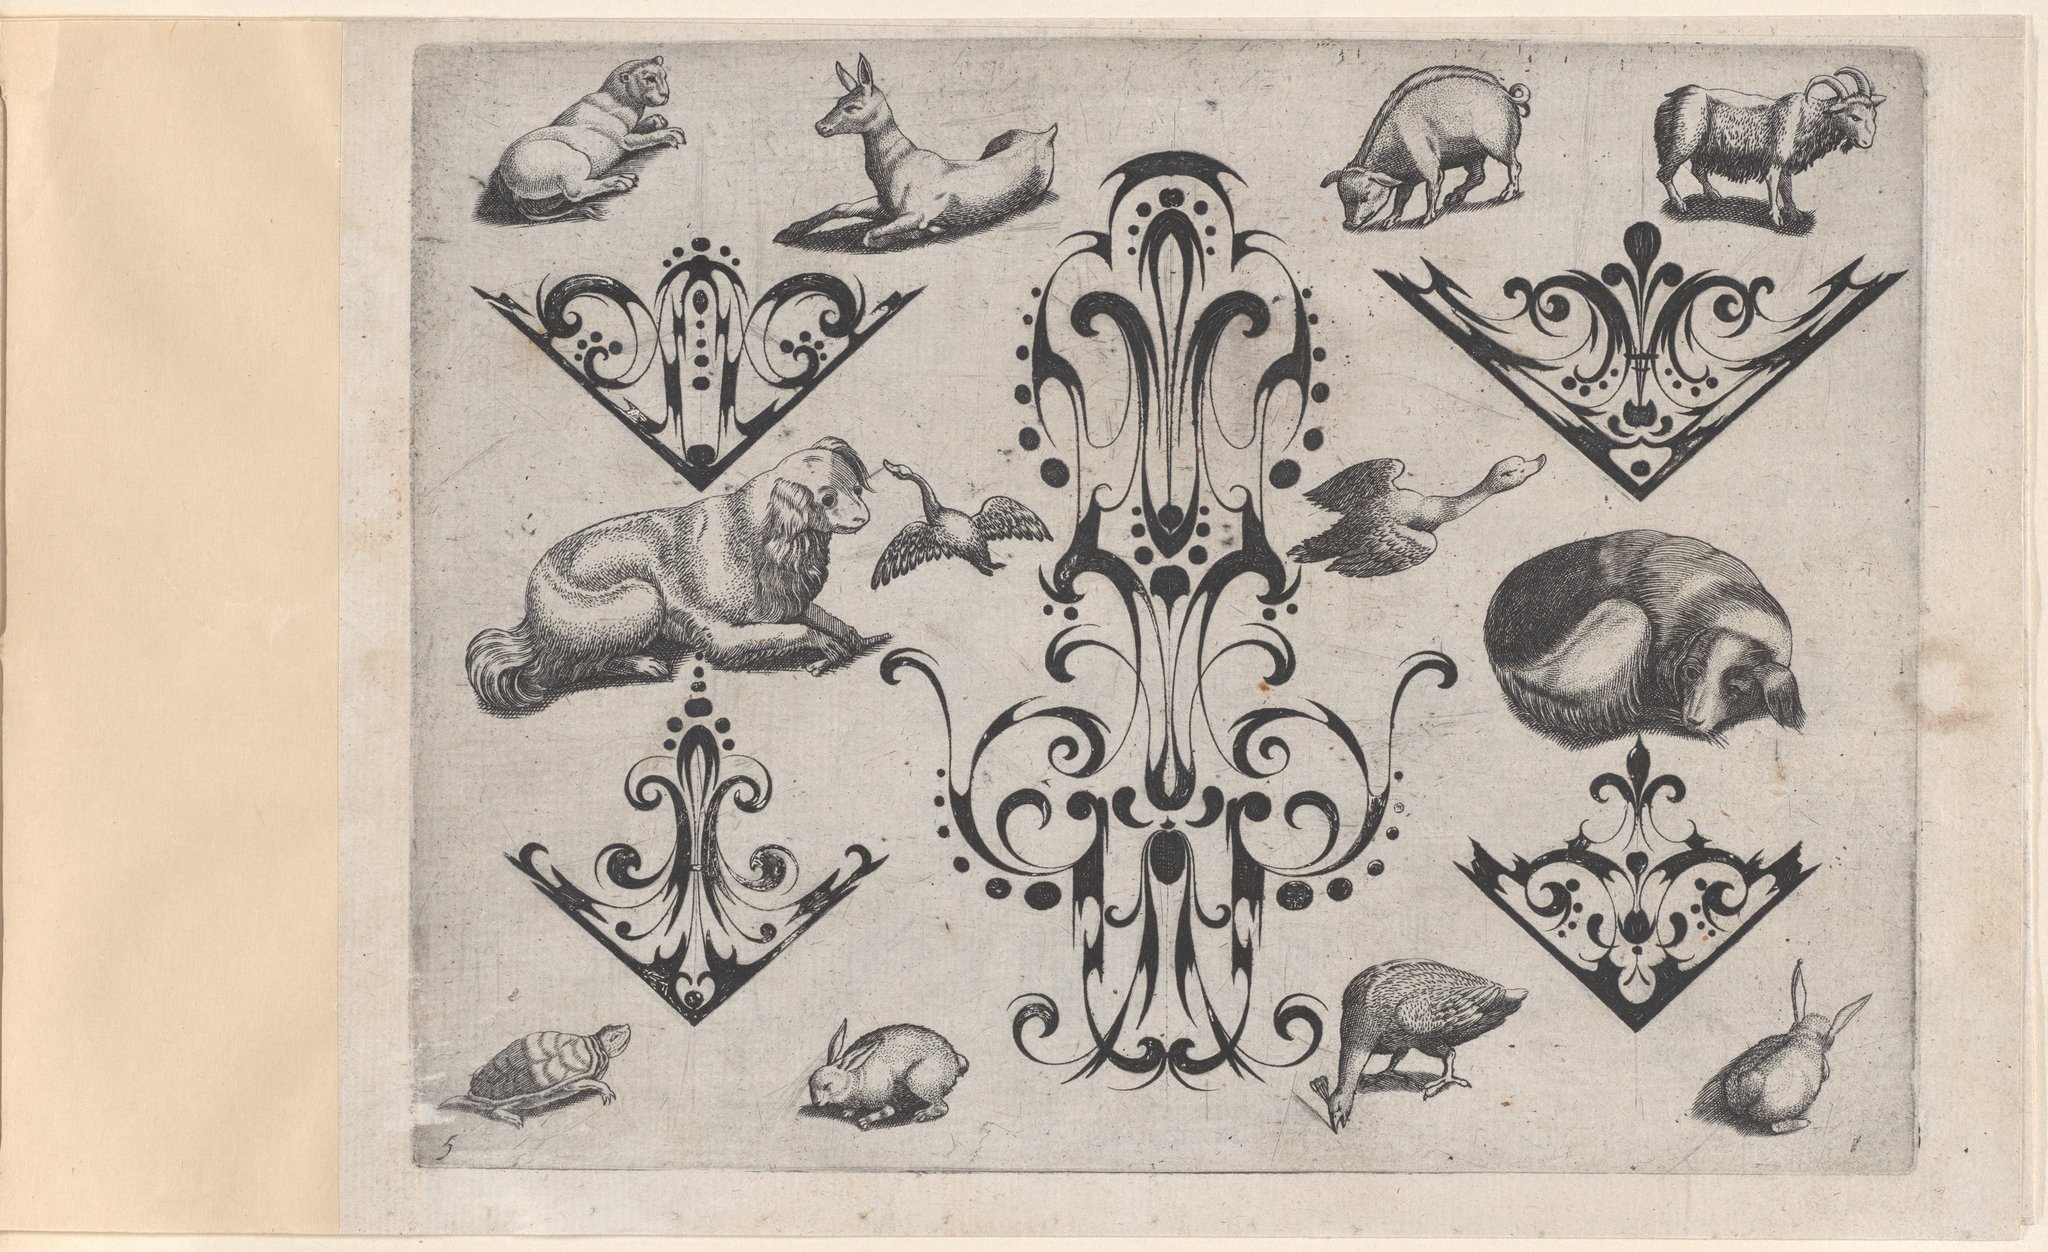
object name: album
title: Blackwork Designs with Various Mammals and Birds, Plate 5 from a Series of Blackwork Ornaments combined with Figures, Birds, Animals and Flowers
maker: meinert gelijs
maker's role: artist and engraver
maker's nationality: dutch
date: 1622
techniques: embroidery, engraving